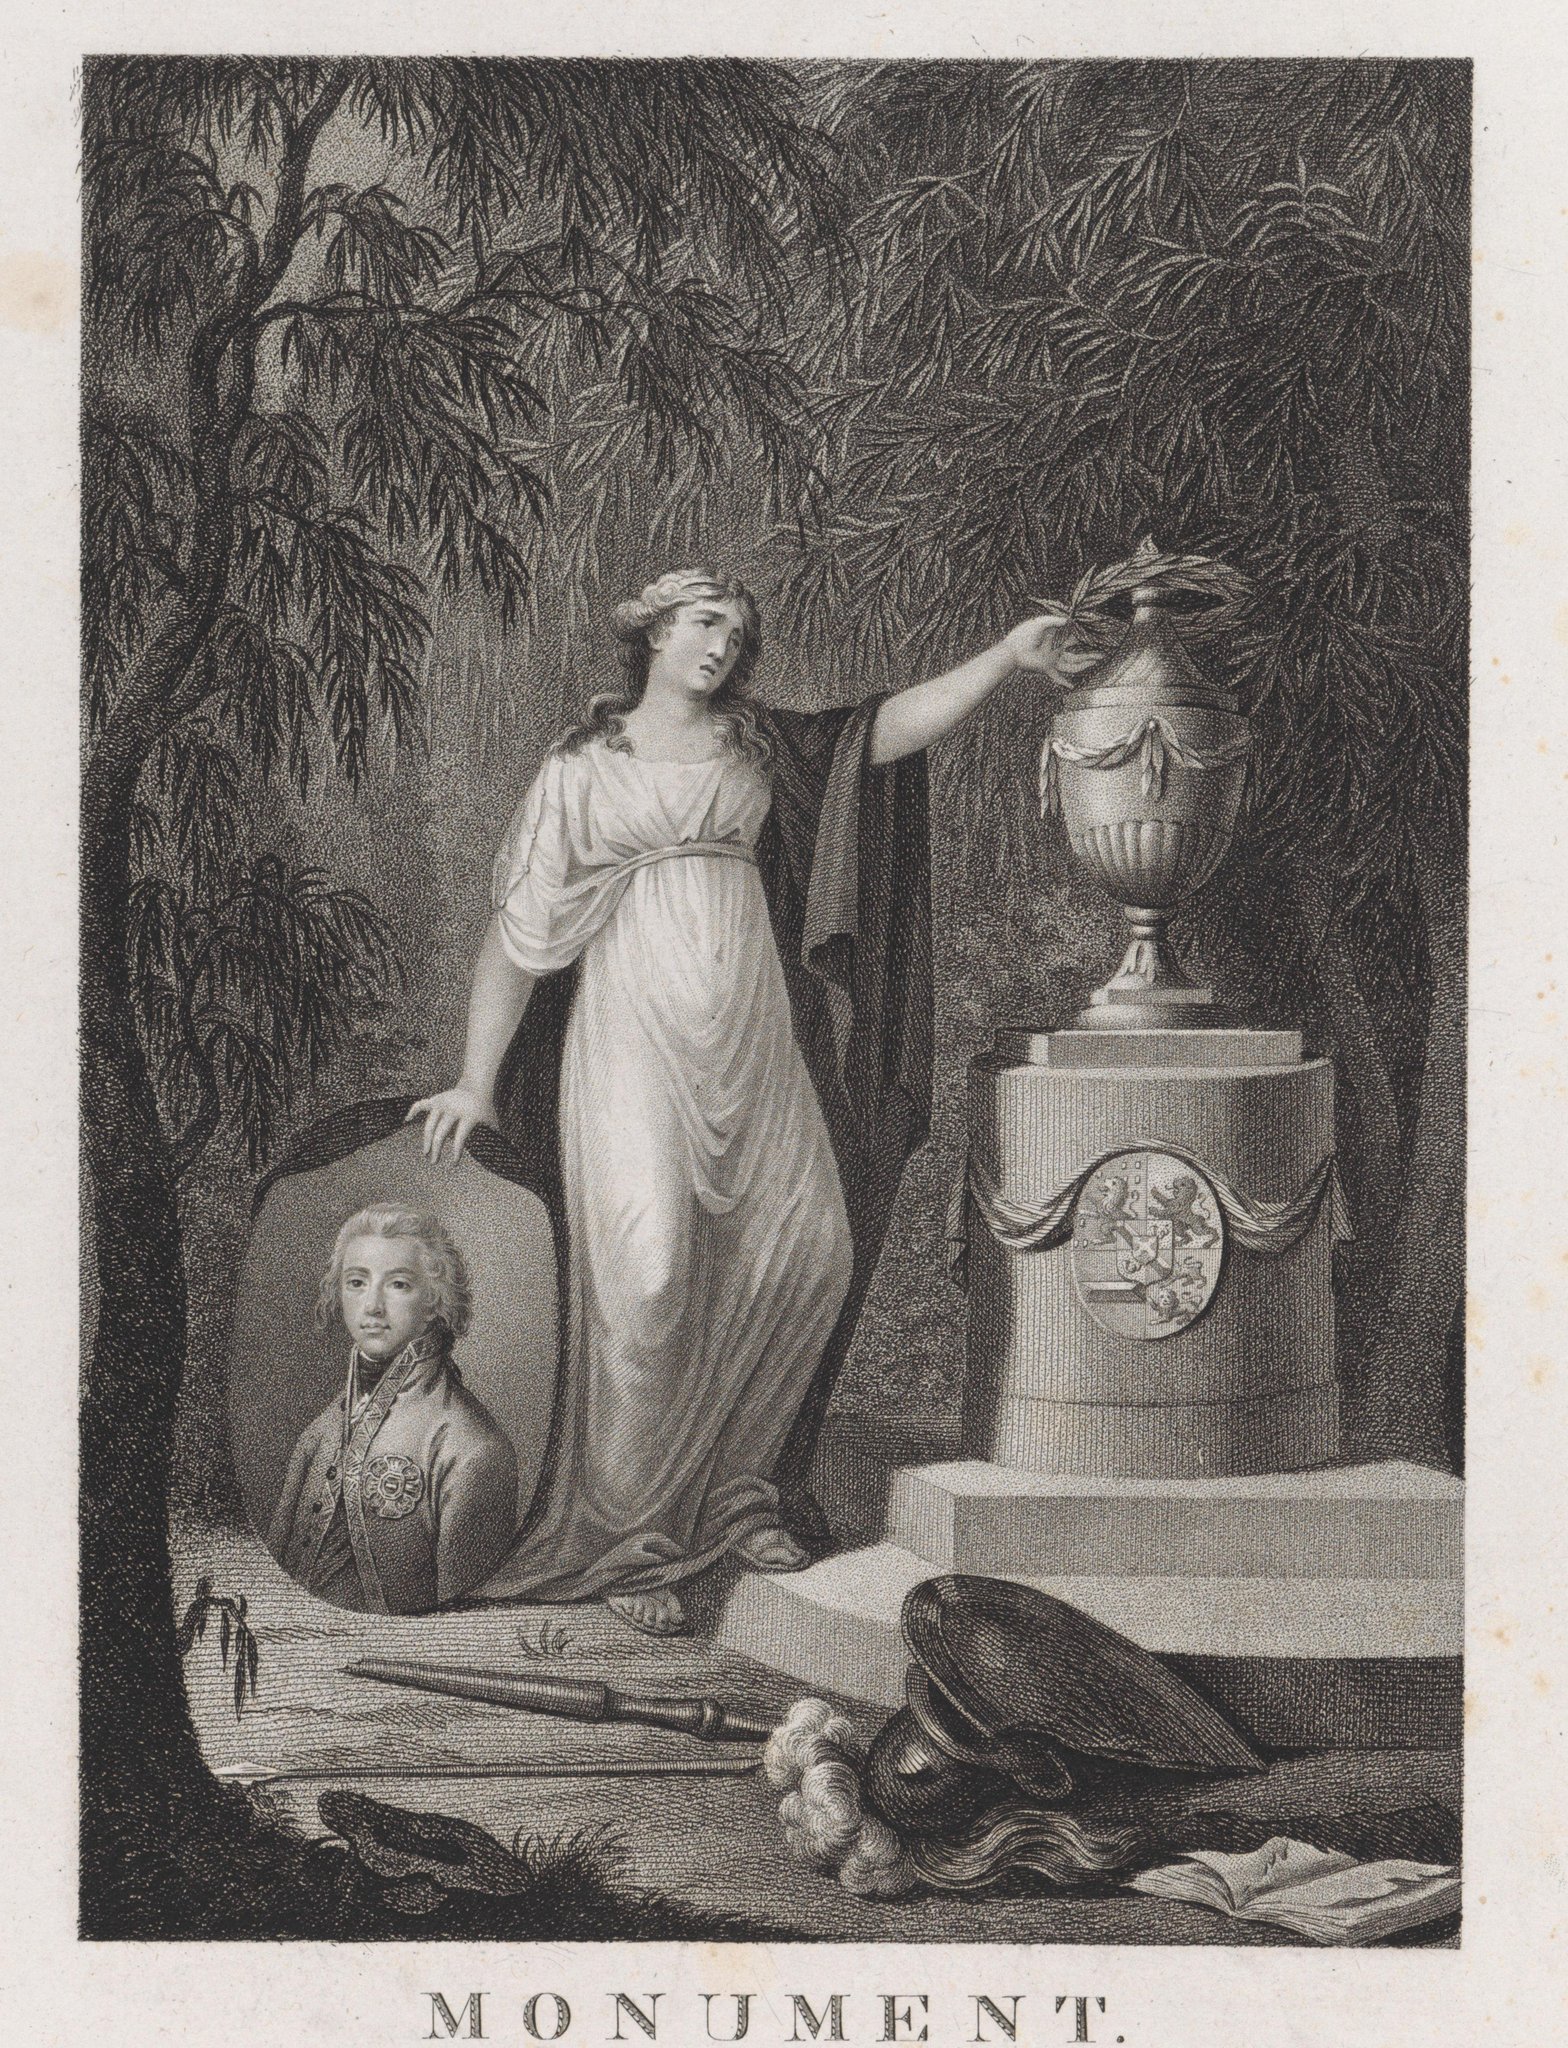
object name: print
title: Allegorisch grafmonument voor prins Frederik, 1799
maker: Anonymous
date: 1806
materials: paper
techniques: engraving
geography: netherlands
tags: willem george frederik (prins van oranje-nassau), personifications of countries, nations, states, districts, etc., grave-building, monumental tomb, netherlands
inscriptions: collector's mark: Lugt 240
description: Allegorisch grafmonument voor Willem George Frederik, prins van Oranje-Nassau, overleden te Padua, 6 januari 1799. De Nederlandse Maagd legt een krans om de urn op het monument in een bos. Links een portret van de prins. Op de grond voor het monument liggen een helm, gebroken schild en speer en een boek met gescheurde bladen.